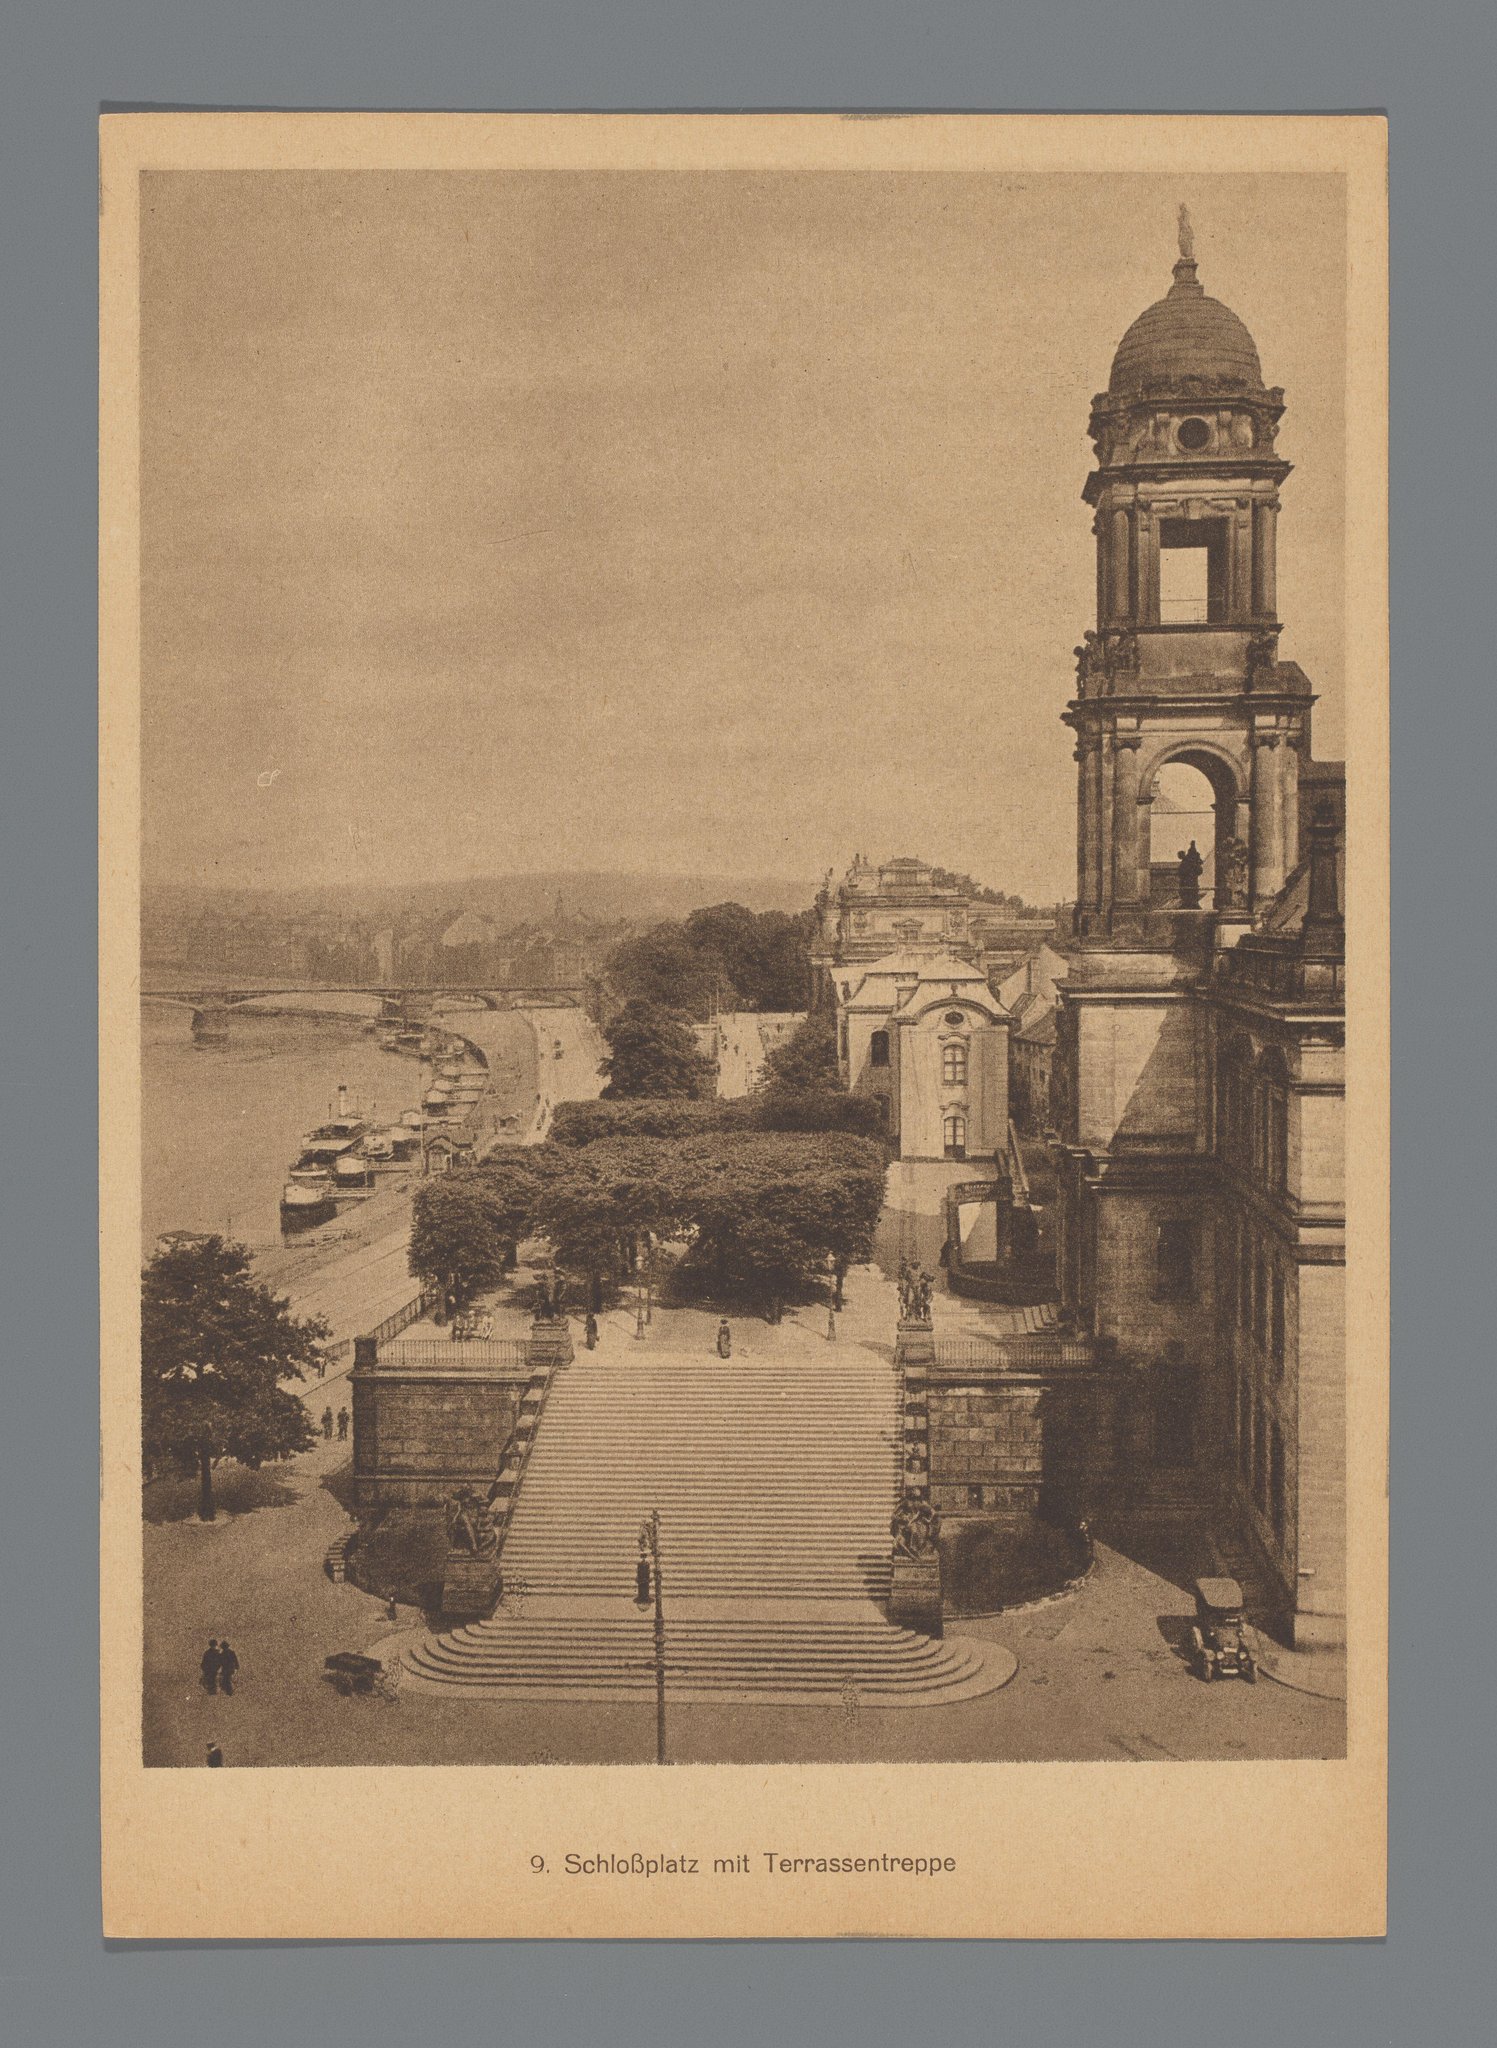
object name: photograph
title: Schloßplatz mit Terrassentreppe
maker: Anonymous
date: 1880-1920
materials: photographic support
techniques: rotogravure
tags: dresden